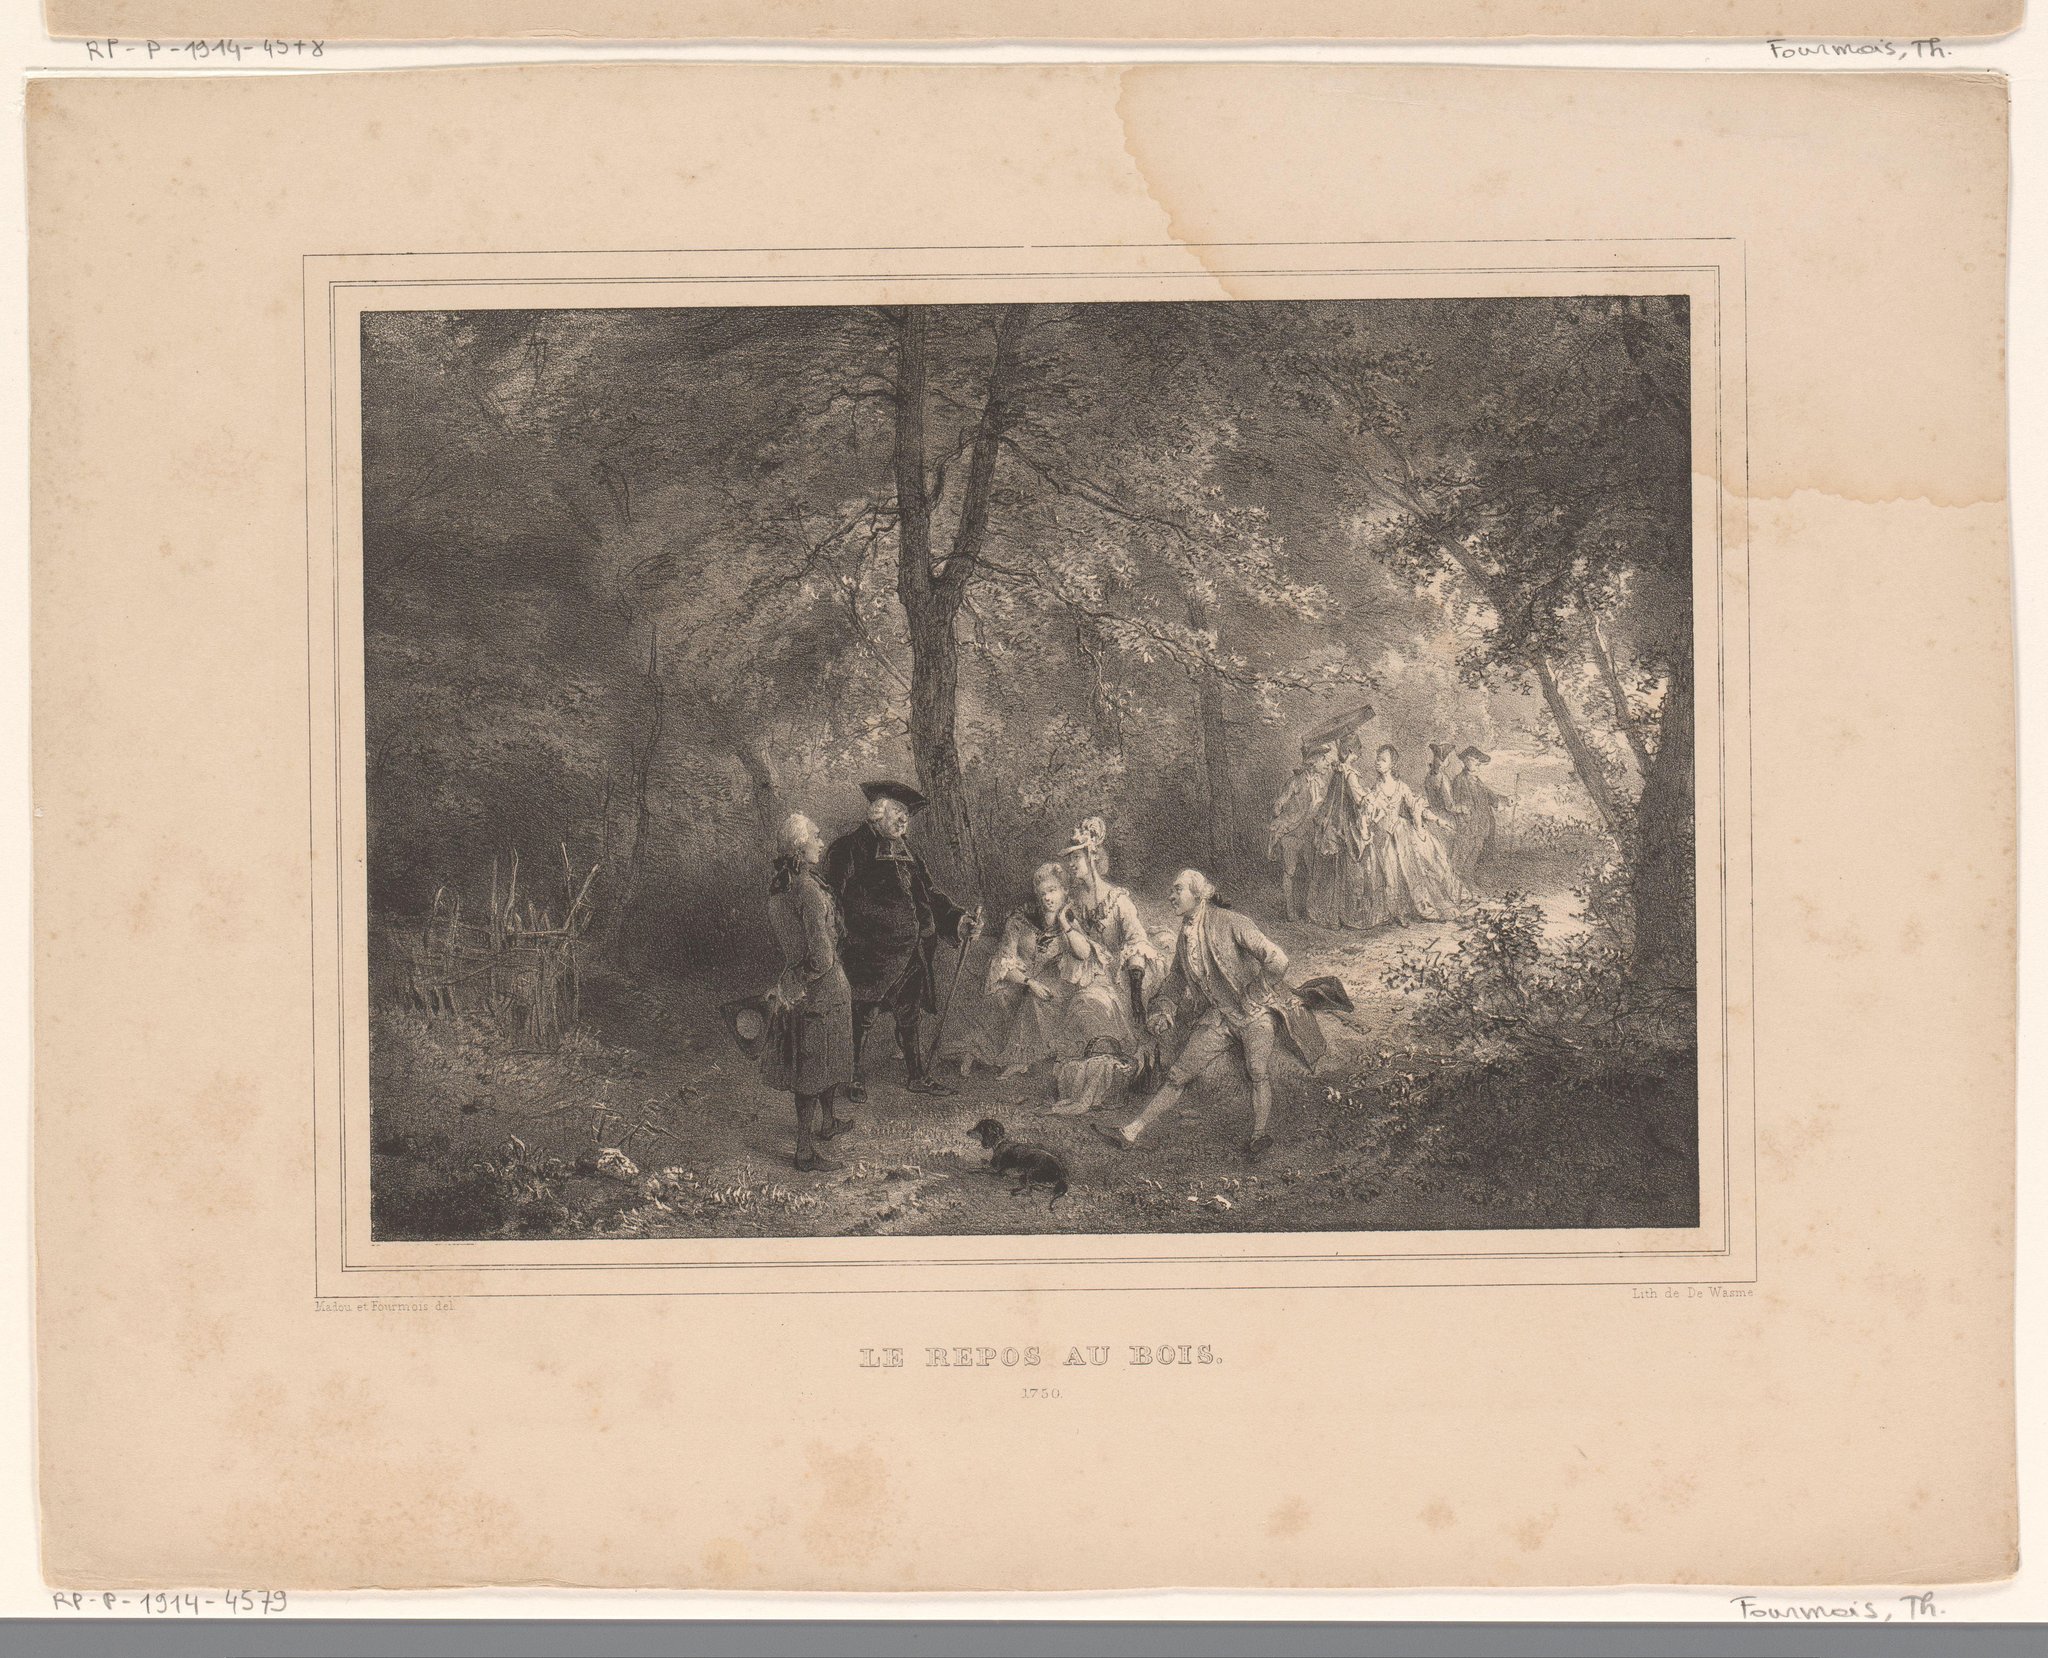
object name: print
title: Gezelschap rust in een bos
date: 1834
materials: paper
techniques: lithograph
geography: brussels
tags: forest, wood, resting - bb - out of doors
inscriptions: collector's mark: Lugt 2228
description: Prent behoort tot een serie met twaalf genretaferelen vervaardigd door Madou en Fourmois. Vier prenten zijn enkel door Madou vervaardigd en de overige prenten door Madou en Fourmois samen. Madou vervaardigde de figuren en Fourmois het landschap.